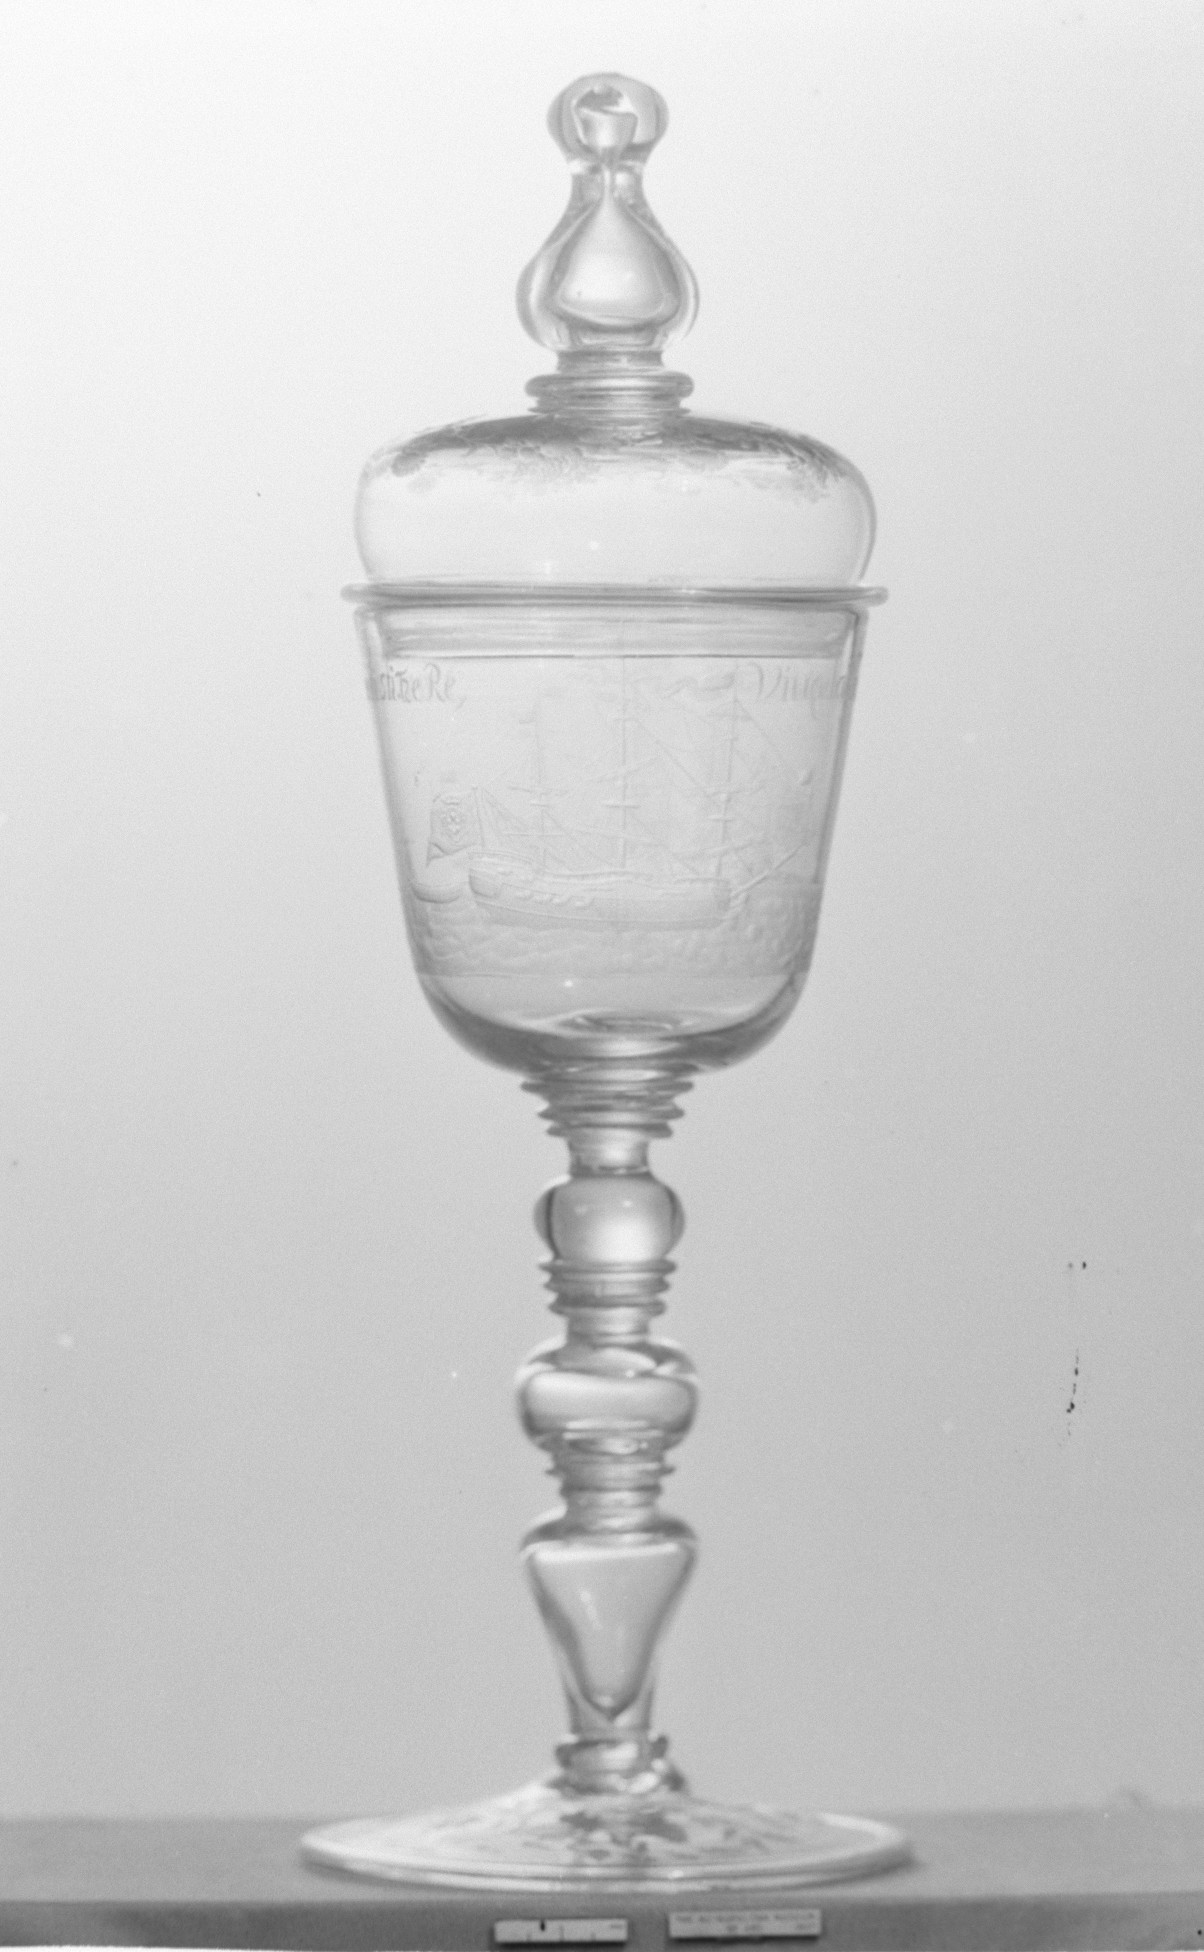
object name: standing cup with cover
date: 1701-1800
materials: glass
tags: ships